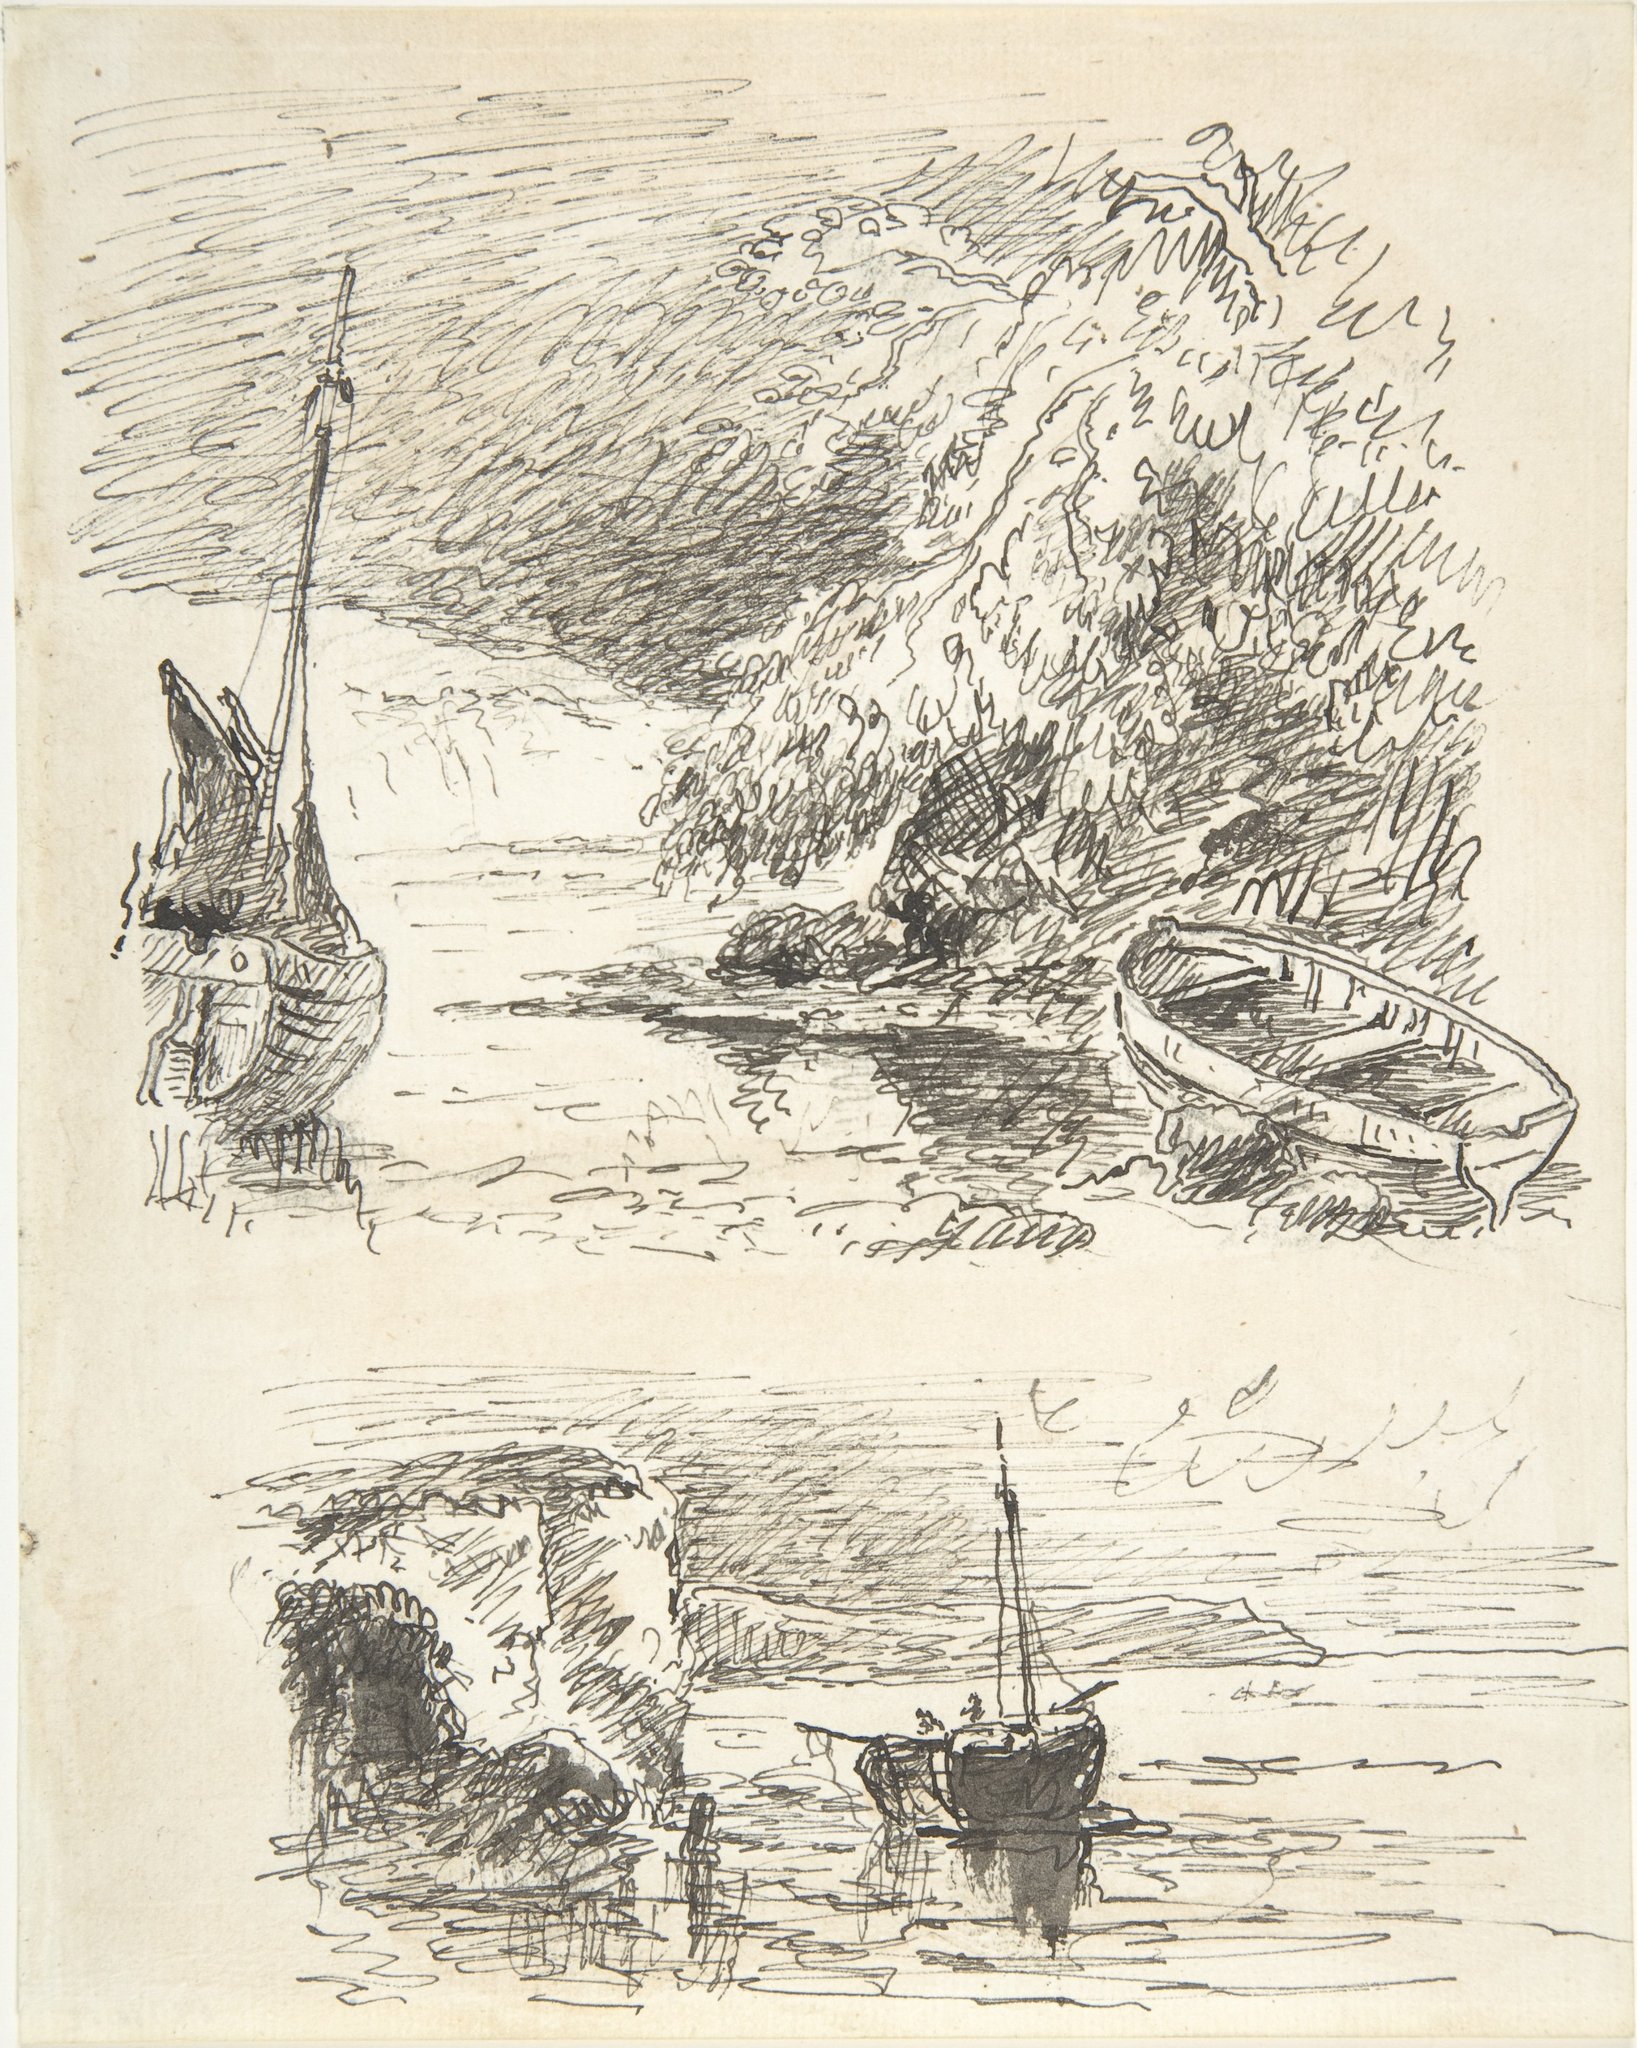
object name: drawing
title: Two Sketches of Boats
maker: anonymous, british, 19th century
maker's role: artist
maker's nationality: british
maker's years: 1800-1900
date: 1801-1900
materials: graphite, ink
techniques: brush, pen, wash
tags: boats